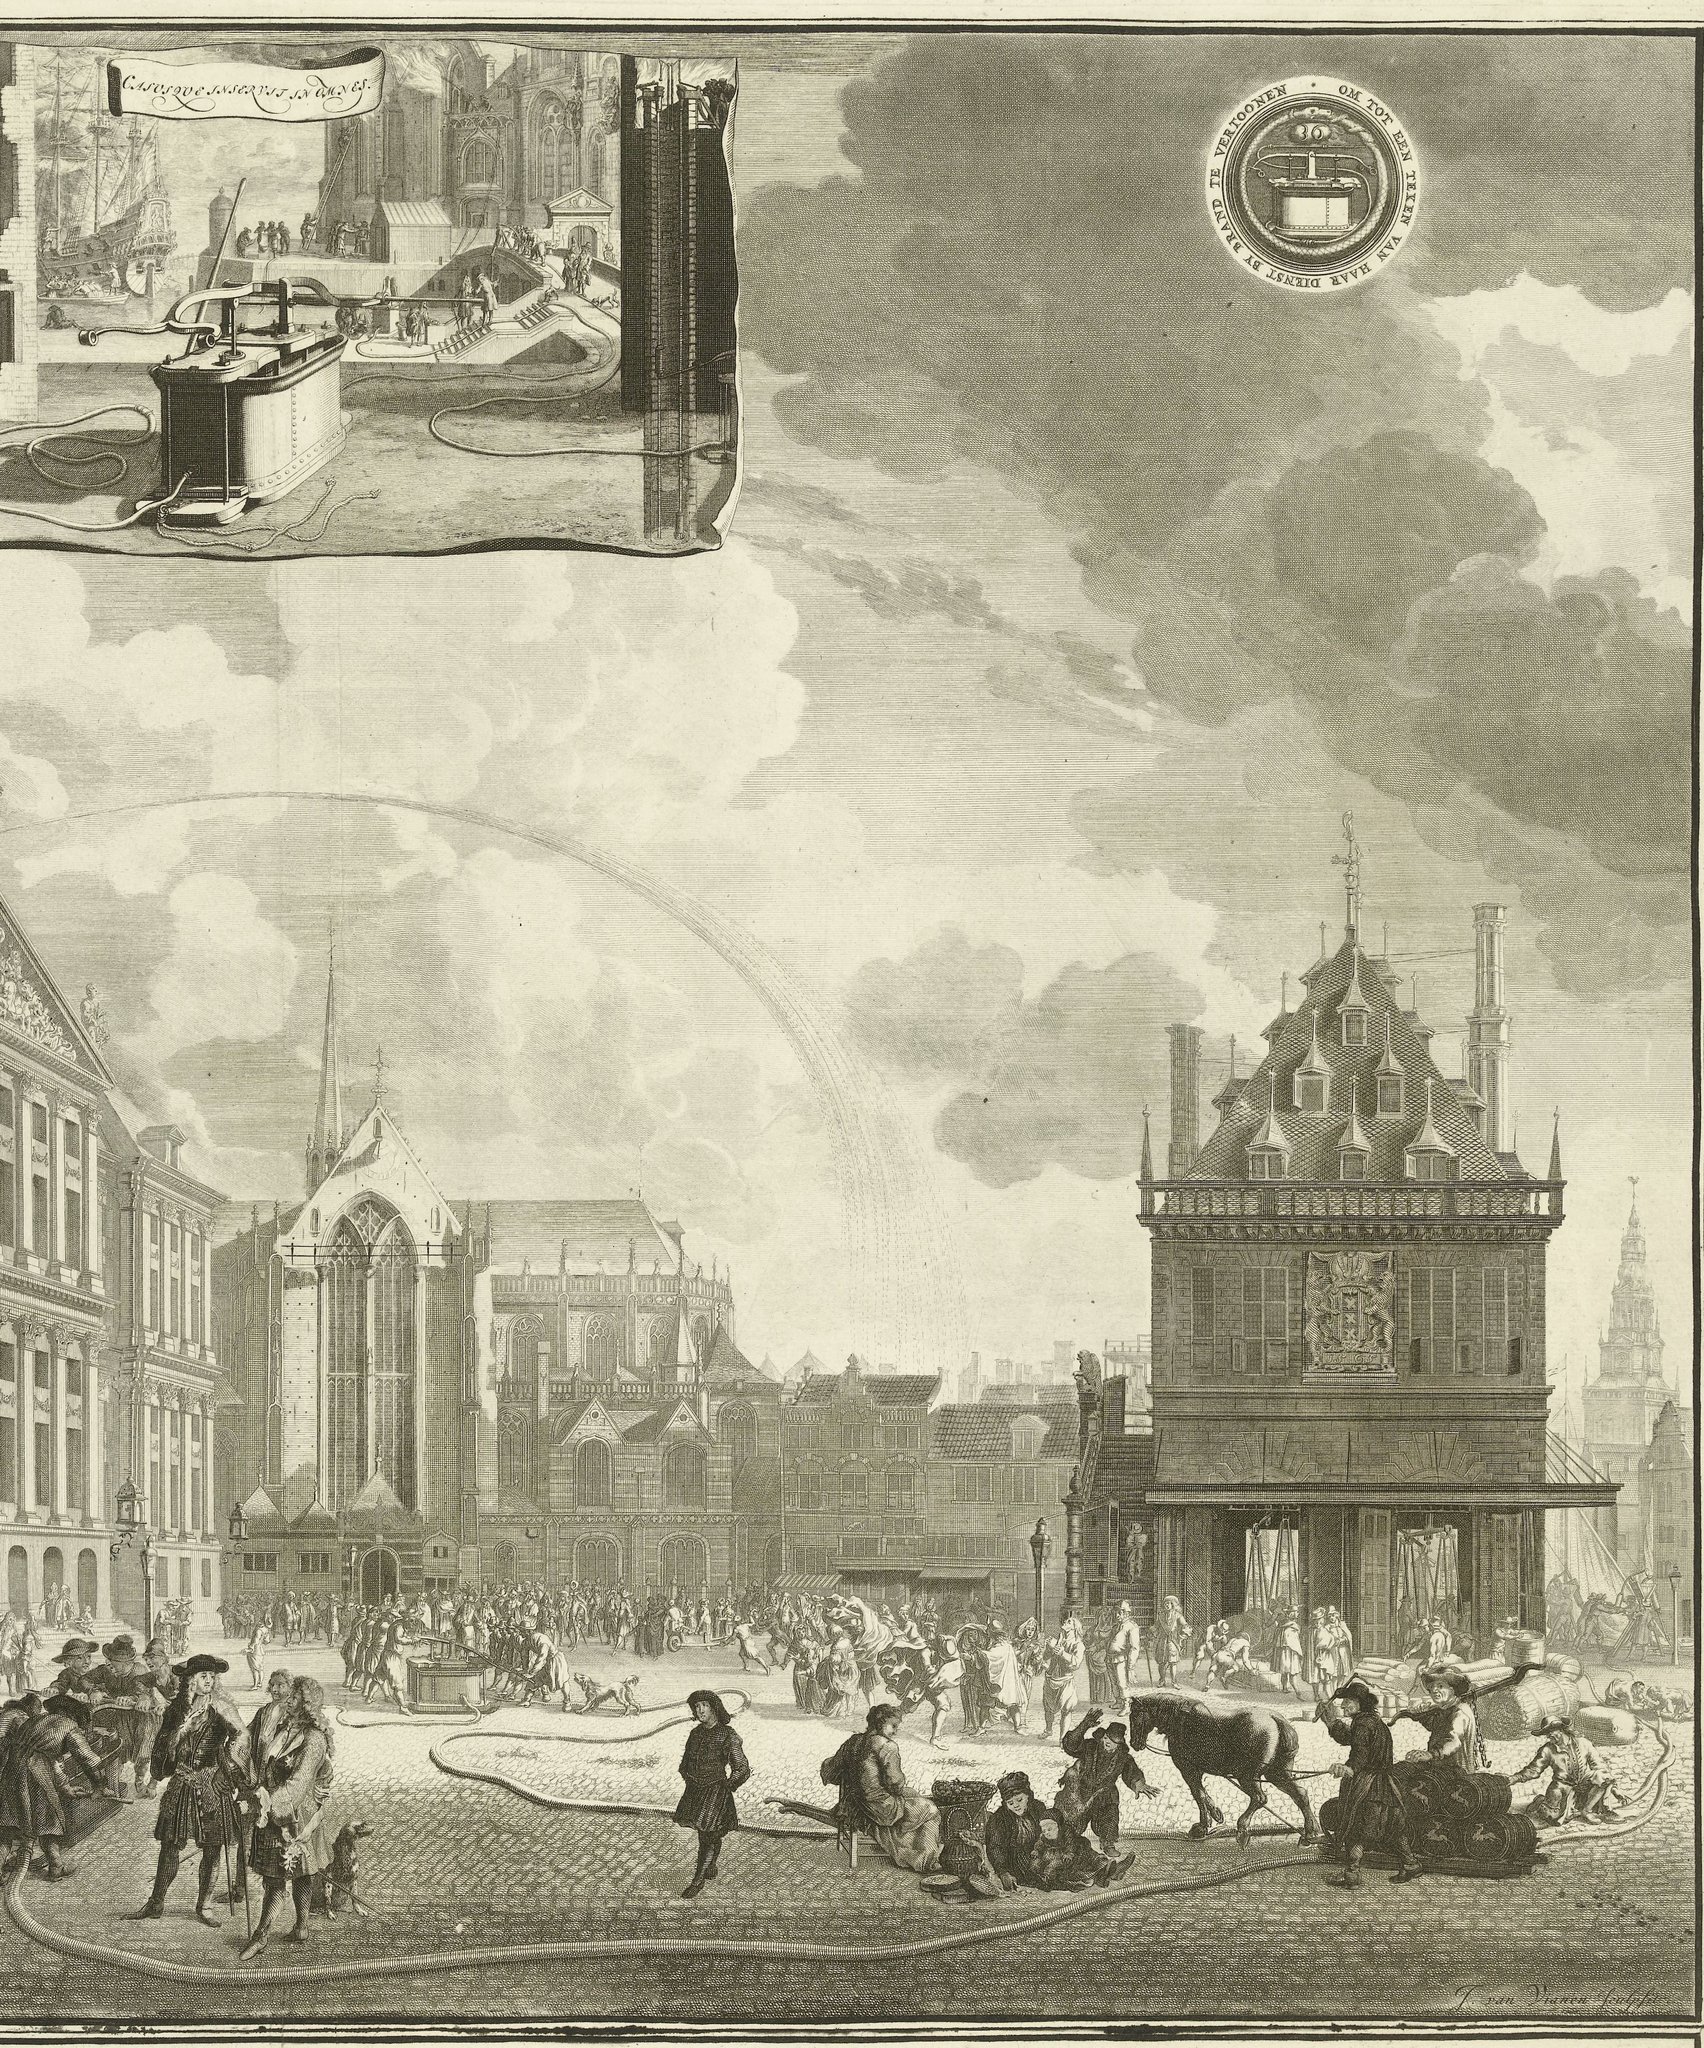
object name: print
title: Demonstratie van de slangbrandspuiten bij het Stadhuis op de Dam, ca. 1700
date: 1690-1710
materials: paper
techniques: engraving, etching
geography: northern netherlands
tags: amsterdam, painter, print maker, draughtsman, jan van der heyden, fire-extinguishing equipment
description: Demonstratie van de slangbrandspuiten bij het Stadhuis op de Dam, ca. 1700. Vanaf de gevel wordt een straal water op de Dam gespoten. In de lucht voor- en keerzijde van een toonpenning en een blad met een pomp. Tegen de onderzijde van de plaat is een tweede plaat afgedrukt waarop de titel en 4 regels tekst staan. Behoort tot de bijprenten bij het Brandspuitenboek van Jan van der Heyden.